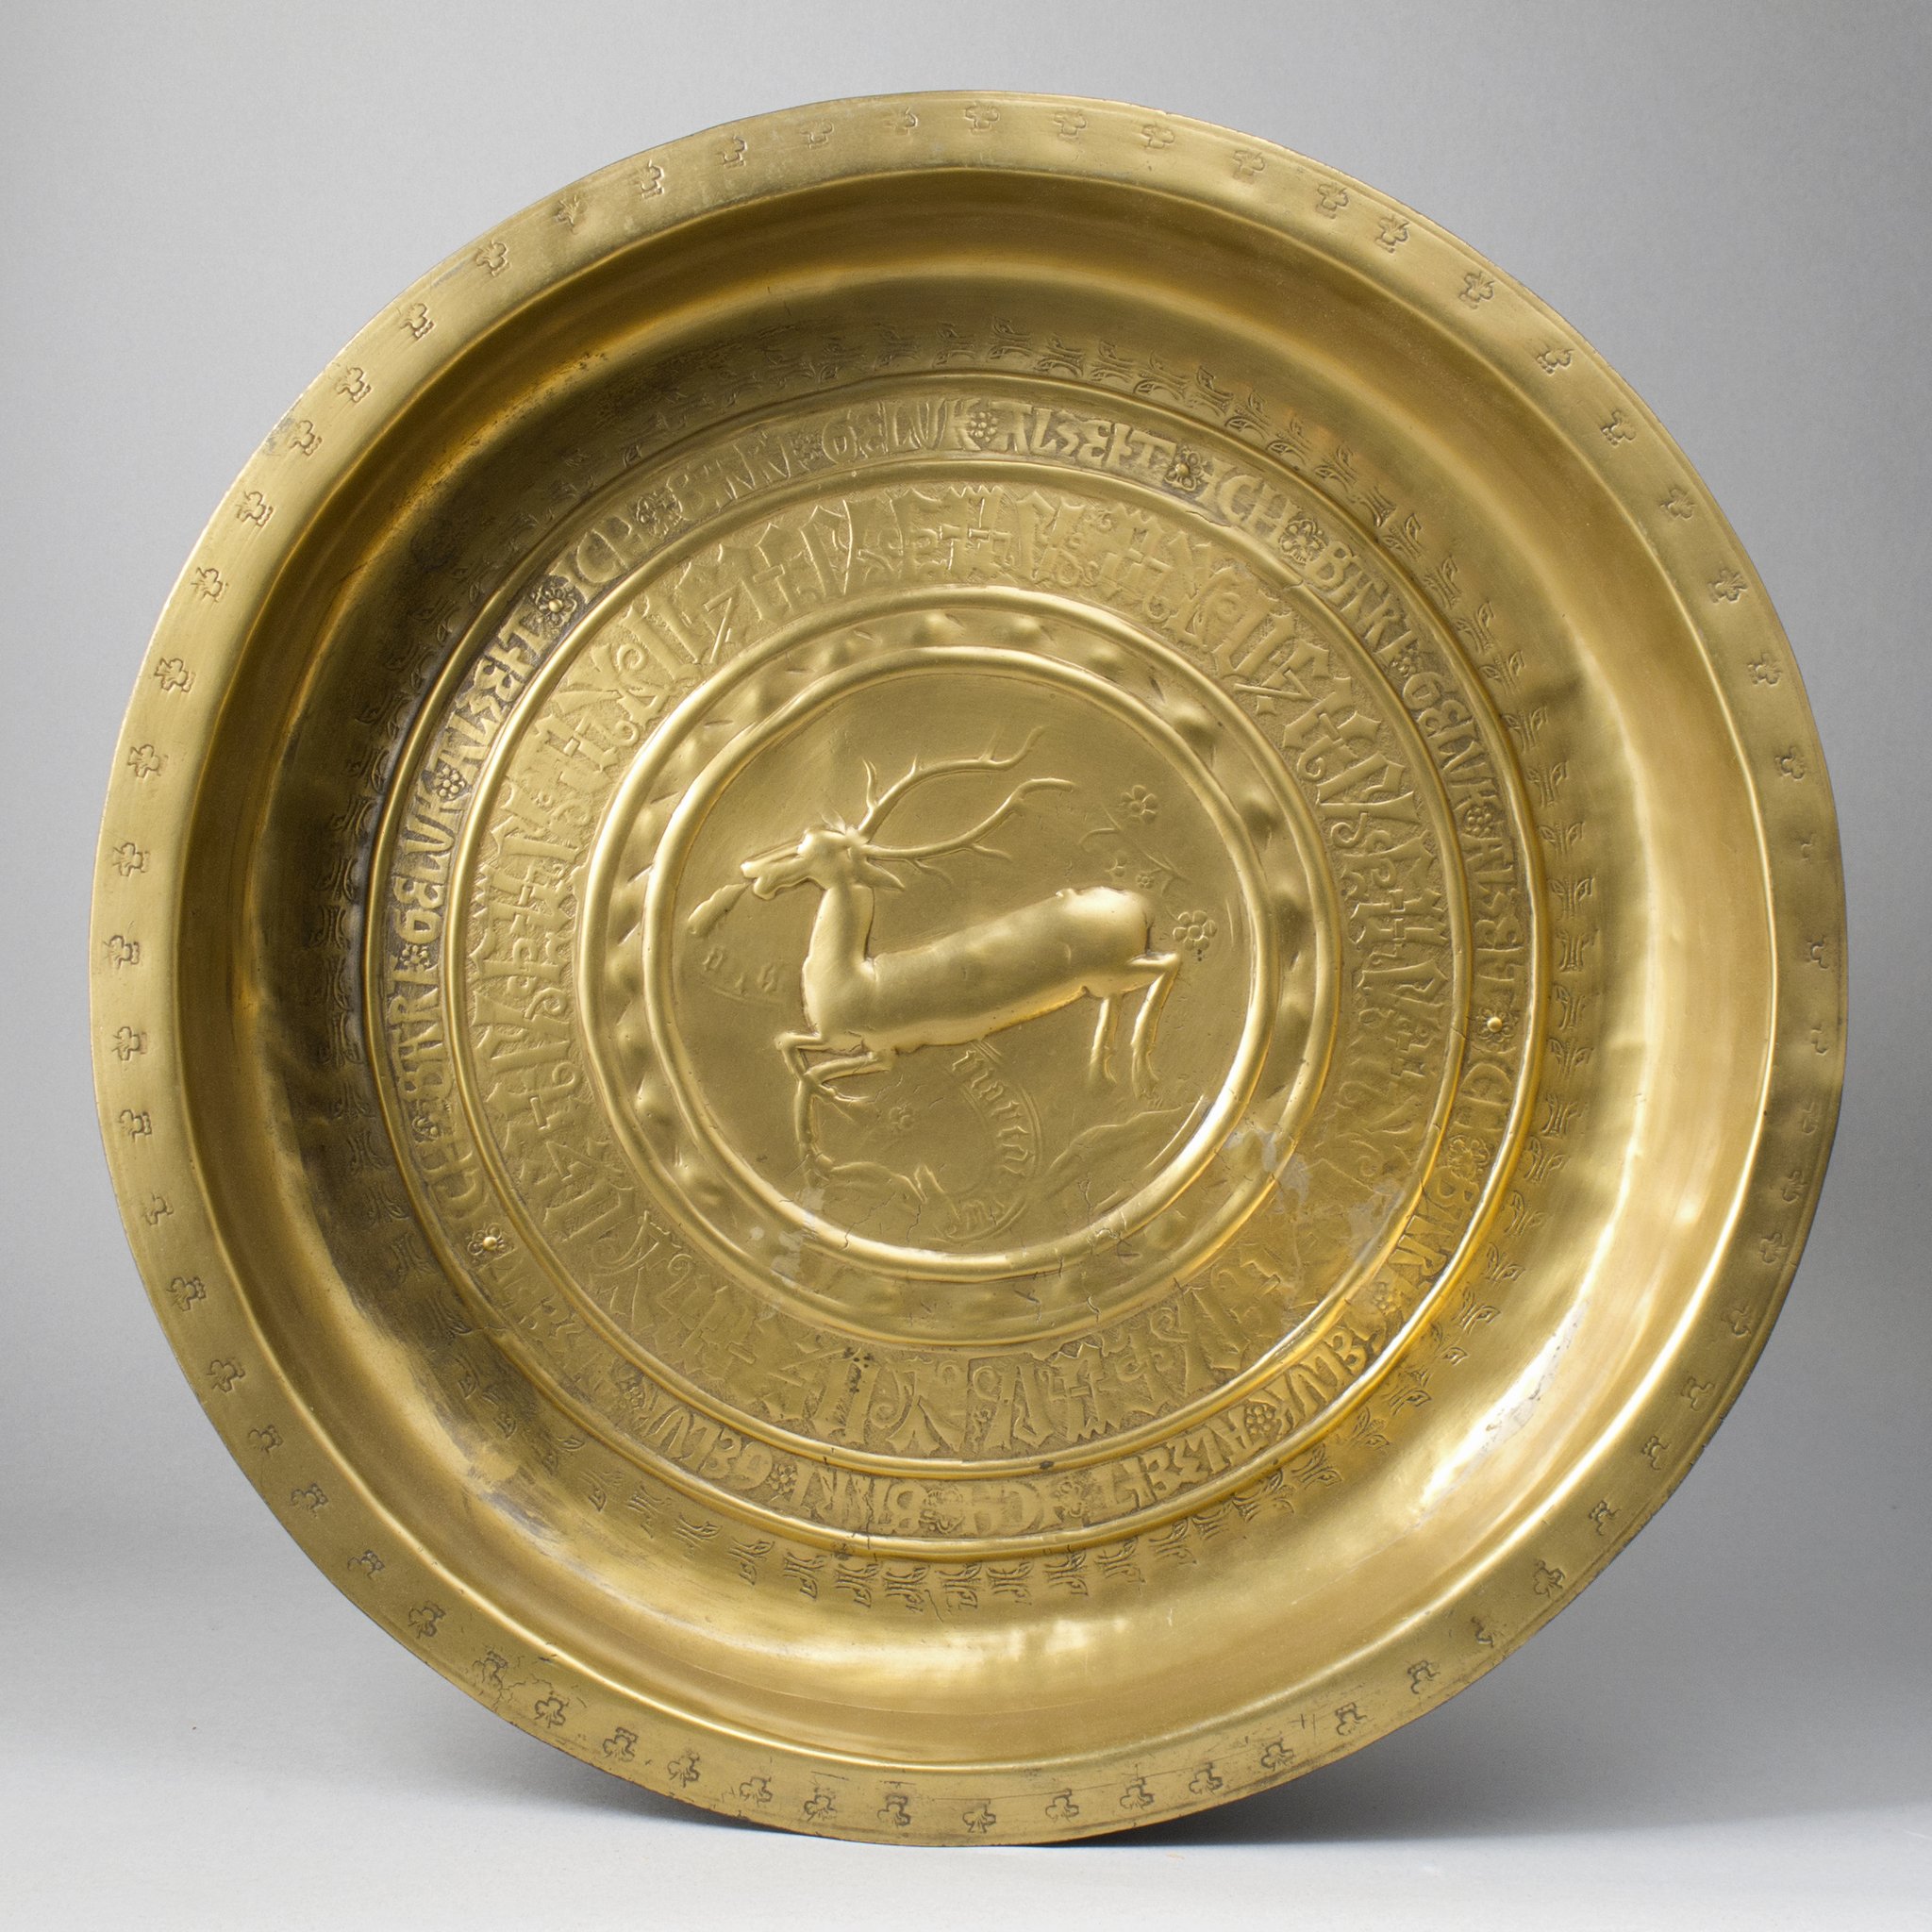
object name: dish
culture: german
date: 1501-1533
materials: brass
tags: deer